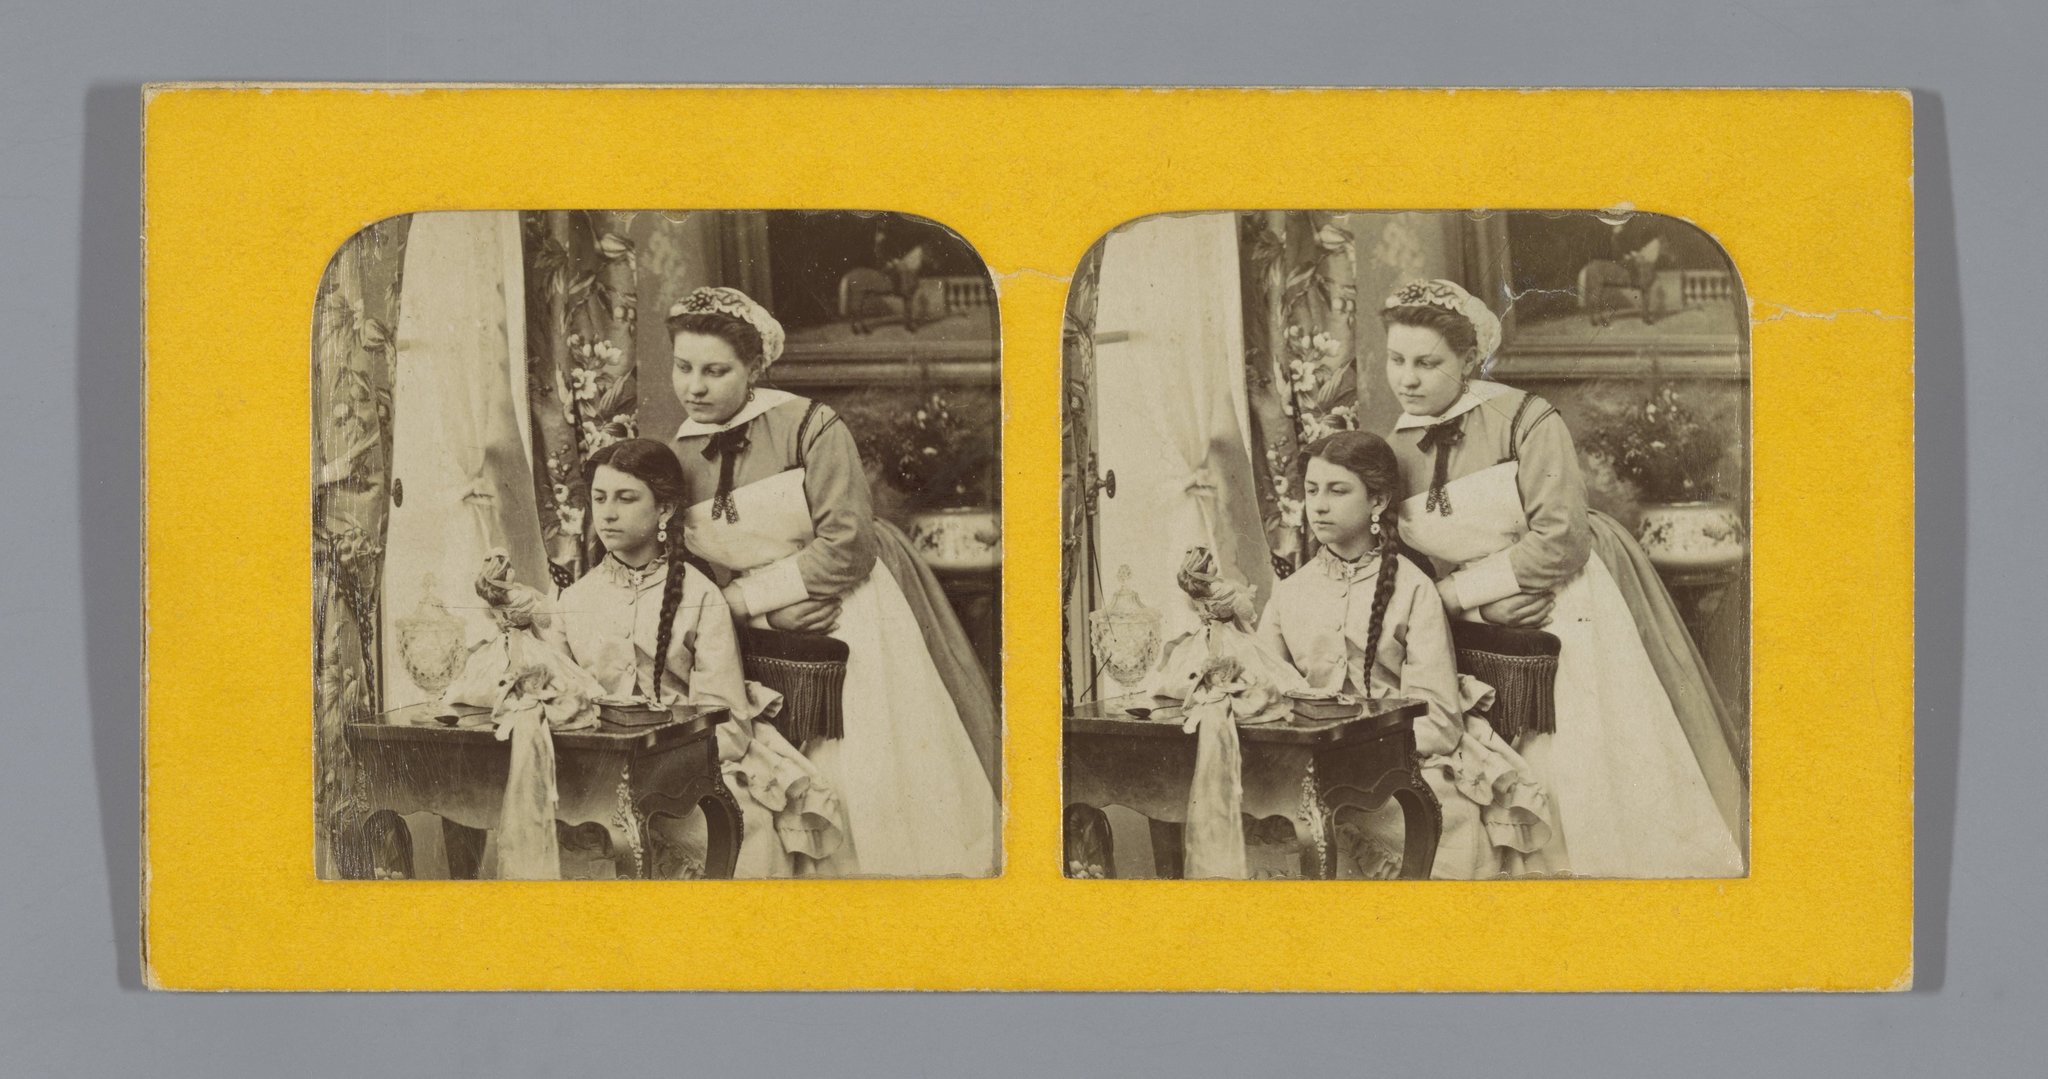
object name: tissue stereograph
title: Jonge vrouw met bediende aan een tafel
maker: Anonymous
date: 1855-1875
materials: cardboard, paper, photographic support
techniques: albumen print, hand coloring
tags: adolescent, young woman, maiden, house personnel, servants